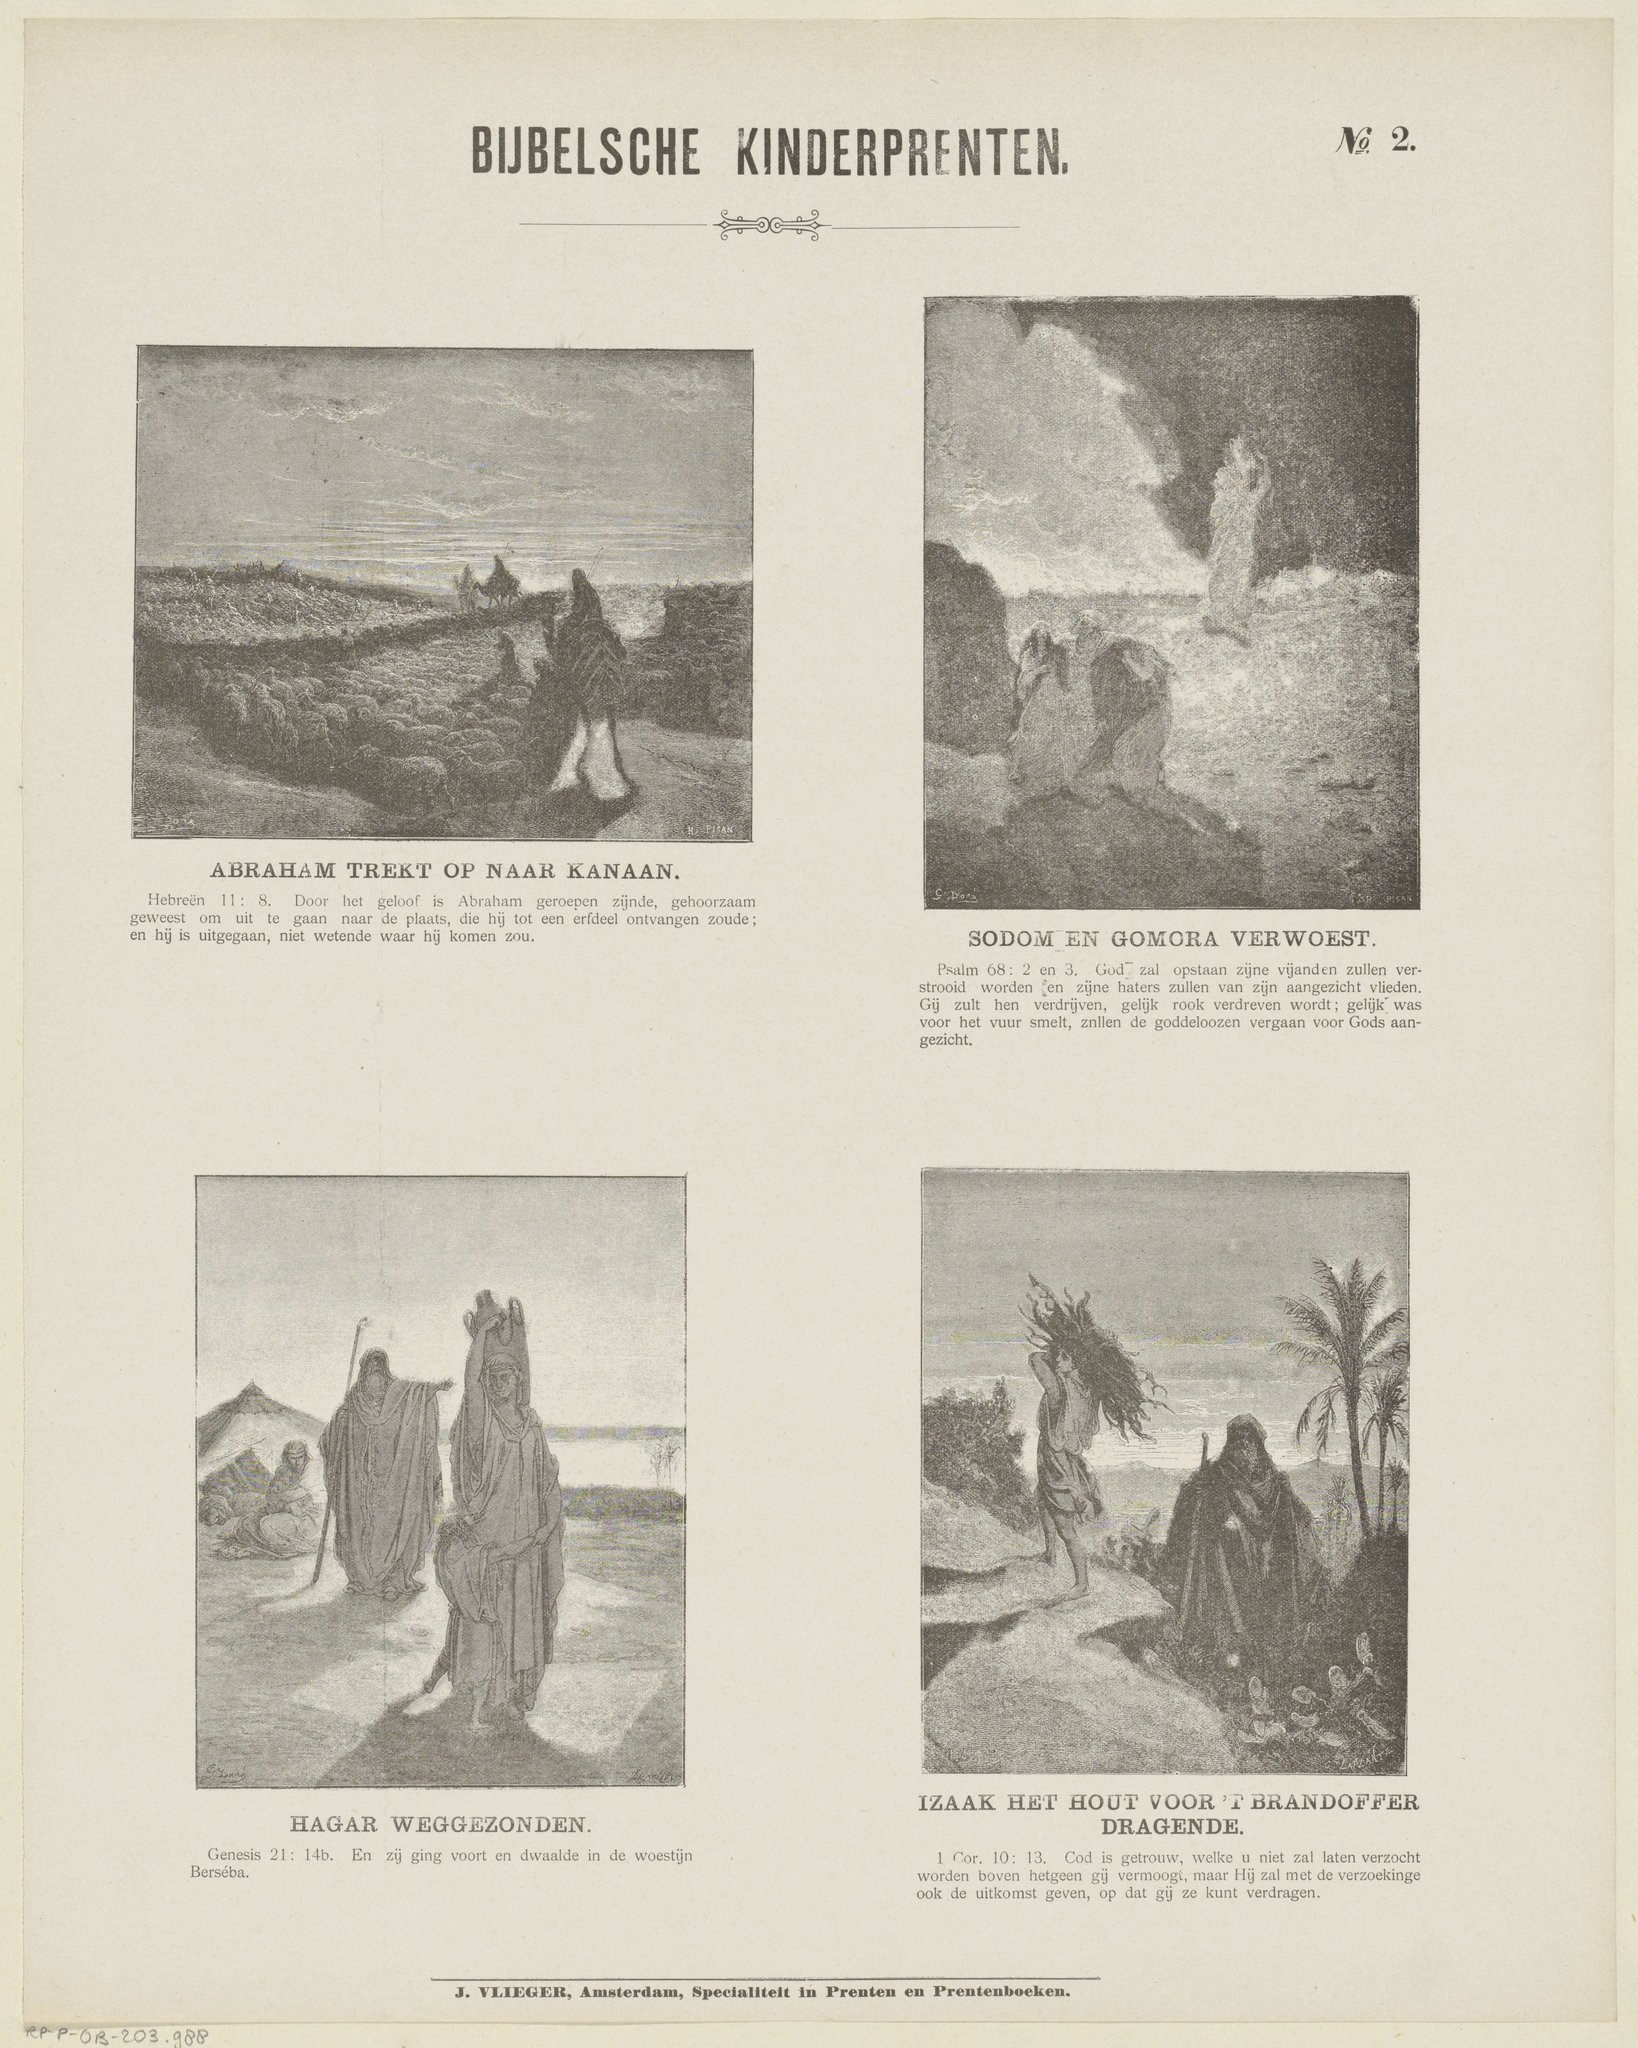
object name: popular print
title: Bijbelsche kinderprenten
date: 1869-1908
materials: paper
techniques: letterpress printing, photoaquatint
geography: amsterdam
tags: the banishment of hagar and ishmael (genesis 21:9-21), story of isaac, the destruction of sodom and gomorrah: lot and his family flee to zoar, carrying their belongings; an angel may be showing the way (genesis 19:24-29), old testament, abraham goes to canaan (genesis 12:1-9)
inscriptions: collector's mark: Lugt 2760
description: Blad met 4 voorstellingen van verhalen uit het Oude Testament. Abraham reist naar Kanaän, Lot en zijn dochter op de vlucht na de verwoesting van Sodom en Gomorra, de verbanning van Hagar en Ismaël en Isaak draagt het hout voor het brandoffer. Onder elke afbeelding een Bijbeltekst. Genummerd rechtsboven: No. 2.